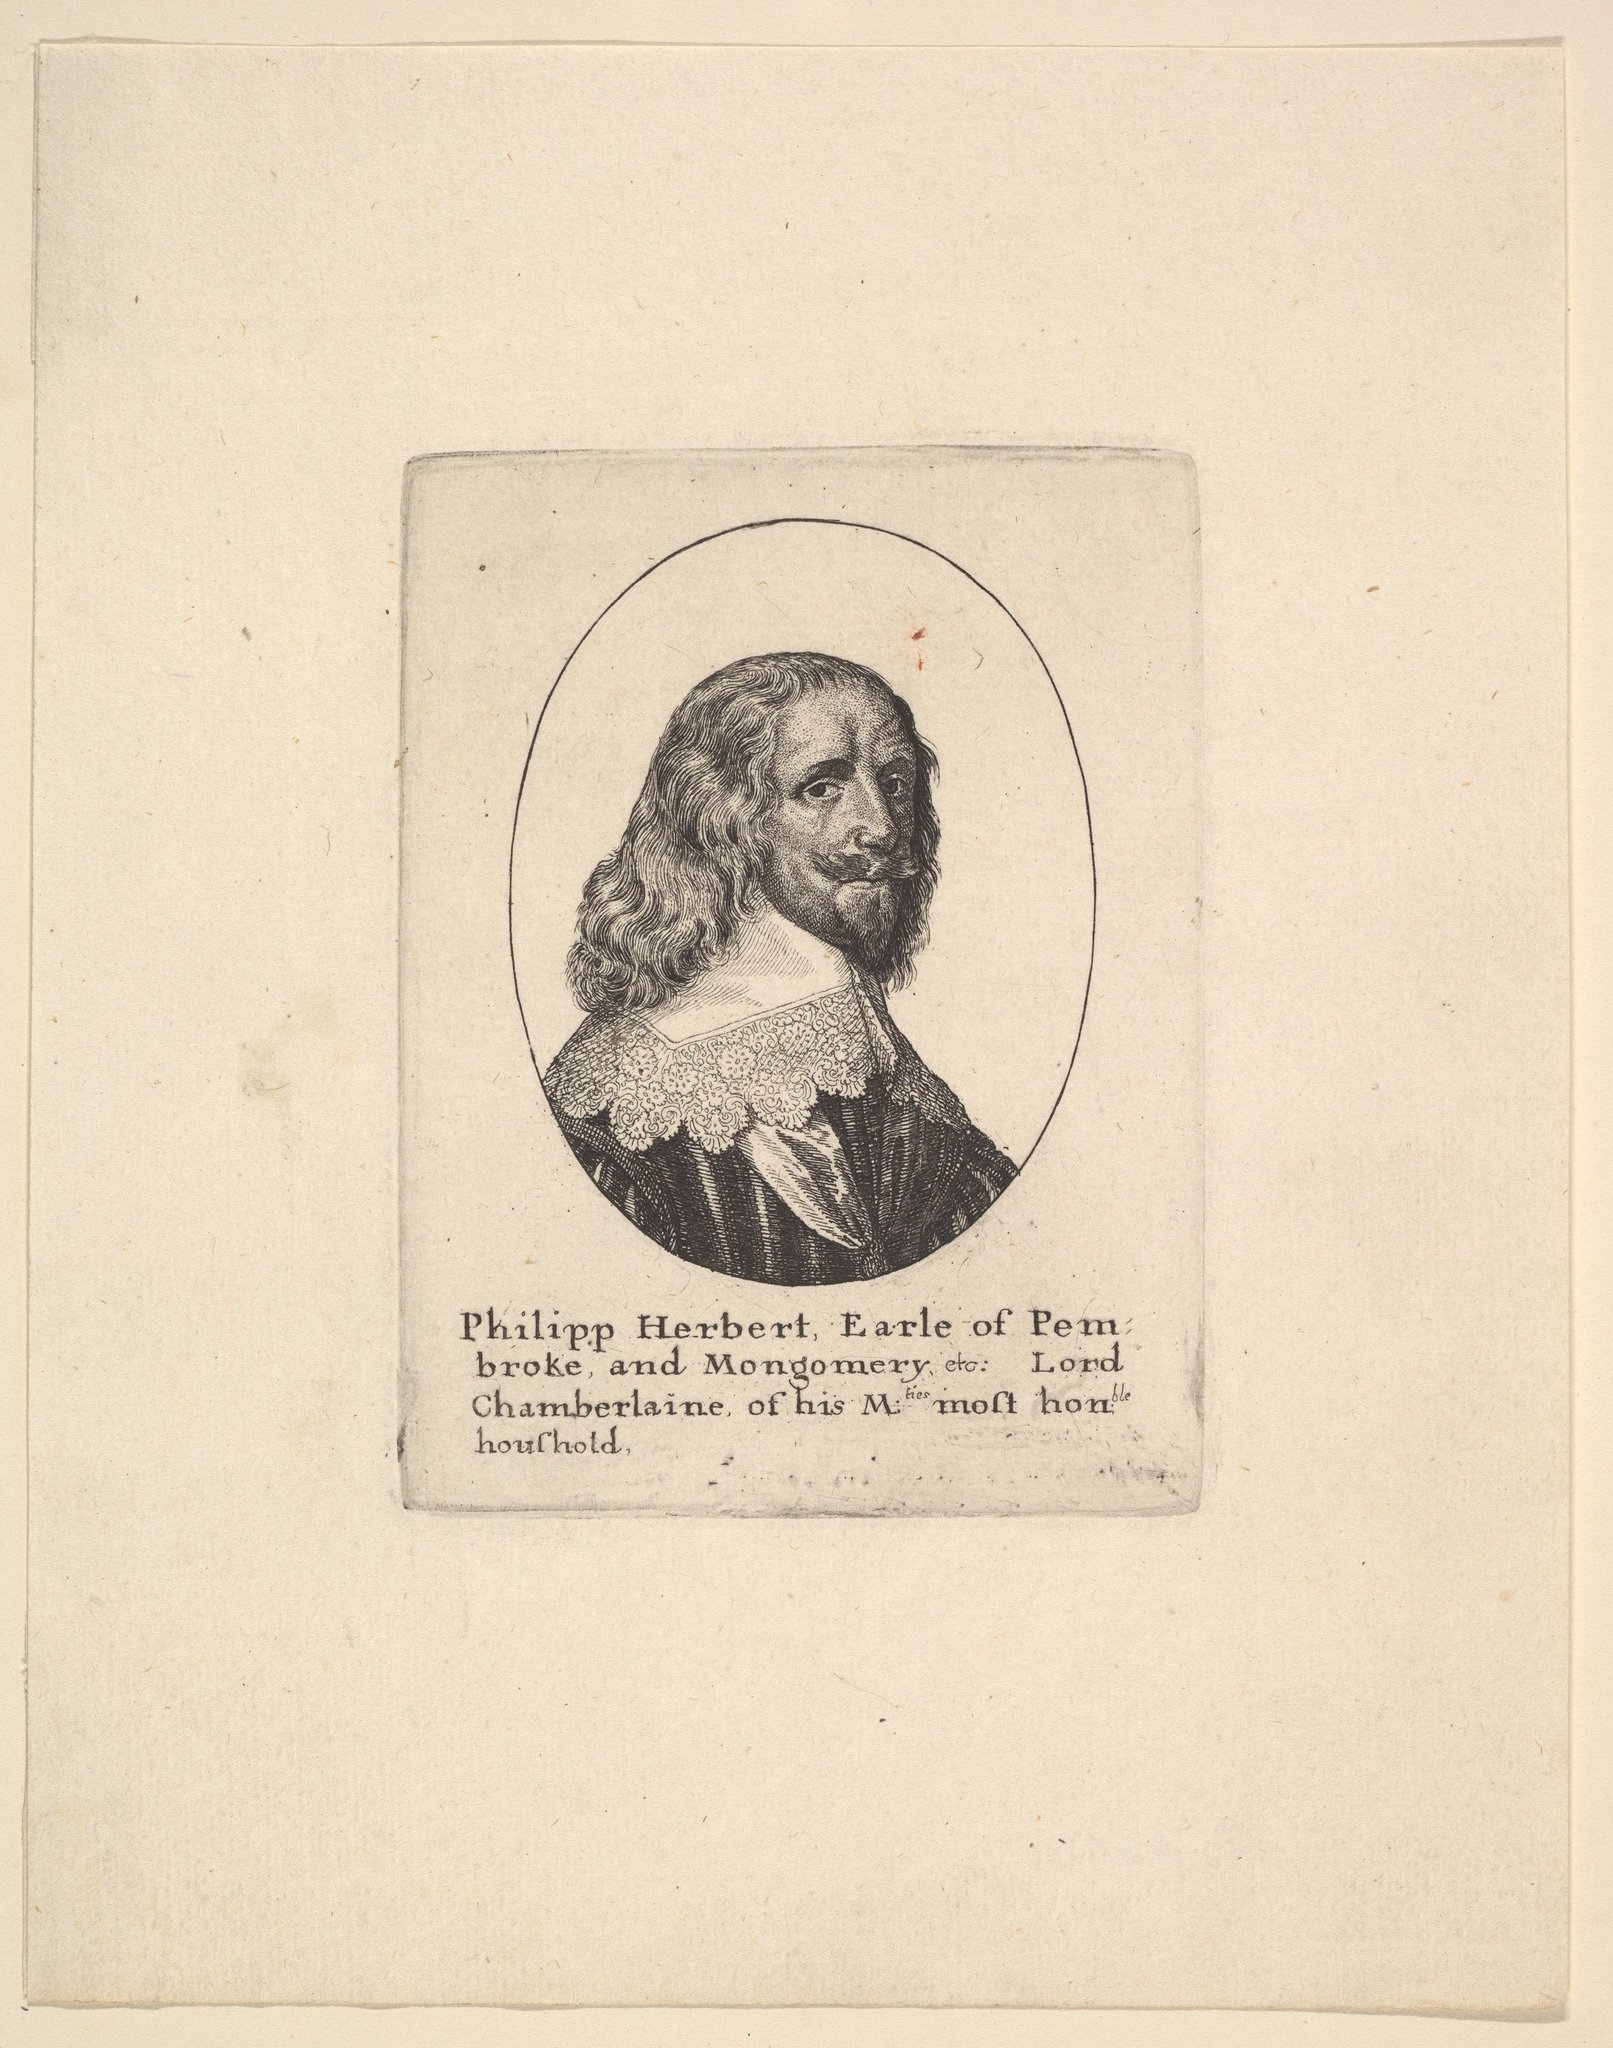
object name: print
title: Philipp Herbert, Earl of Pembroke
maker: wenceslaus hollar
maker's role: artist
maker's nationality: bohemian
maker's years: 1607-1677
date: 1625-1677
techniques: etching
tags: men,portraits